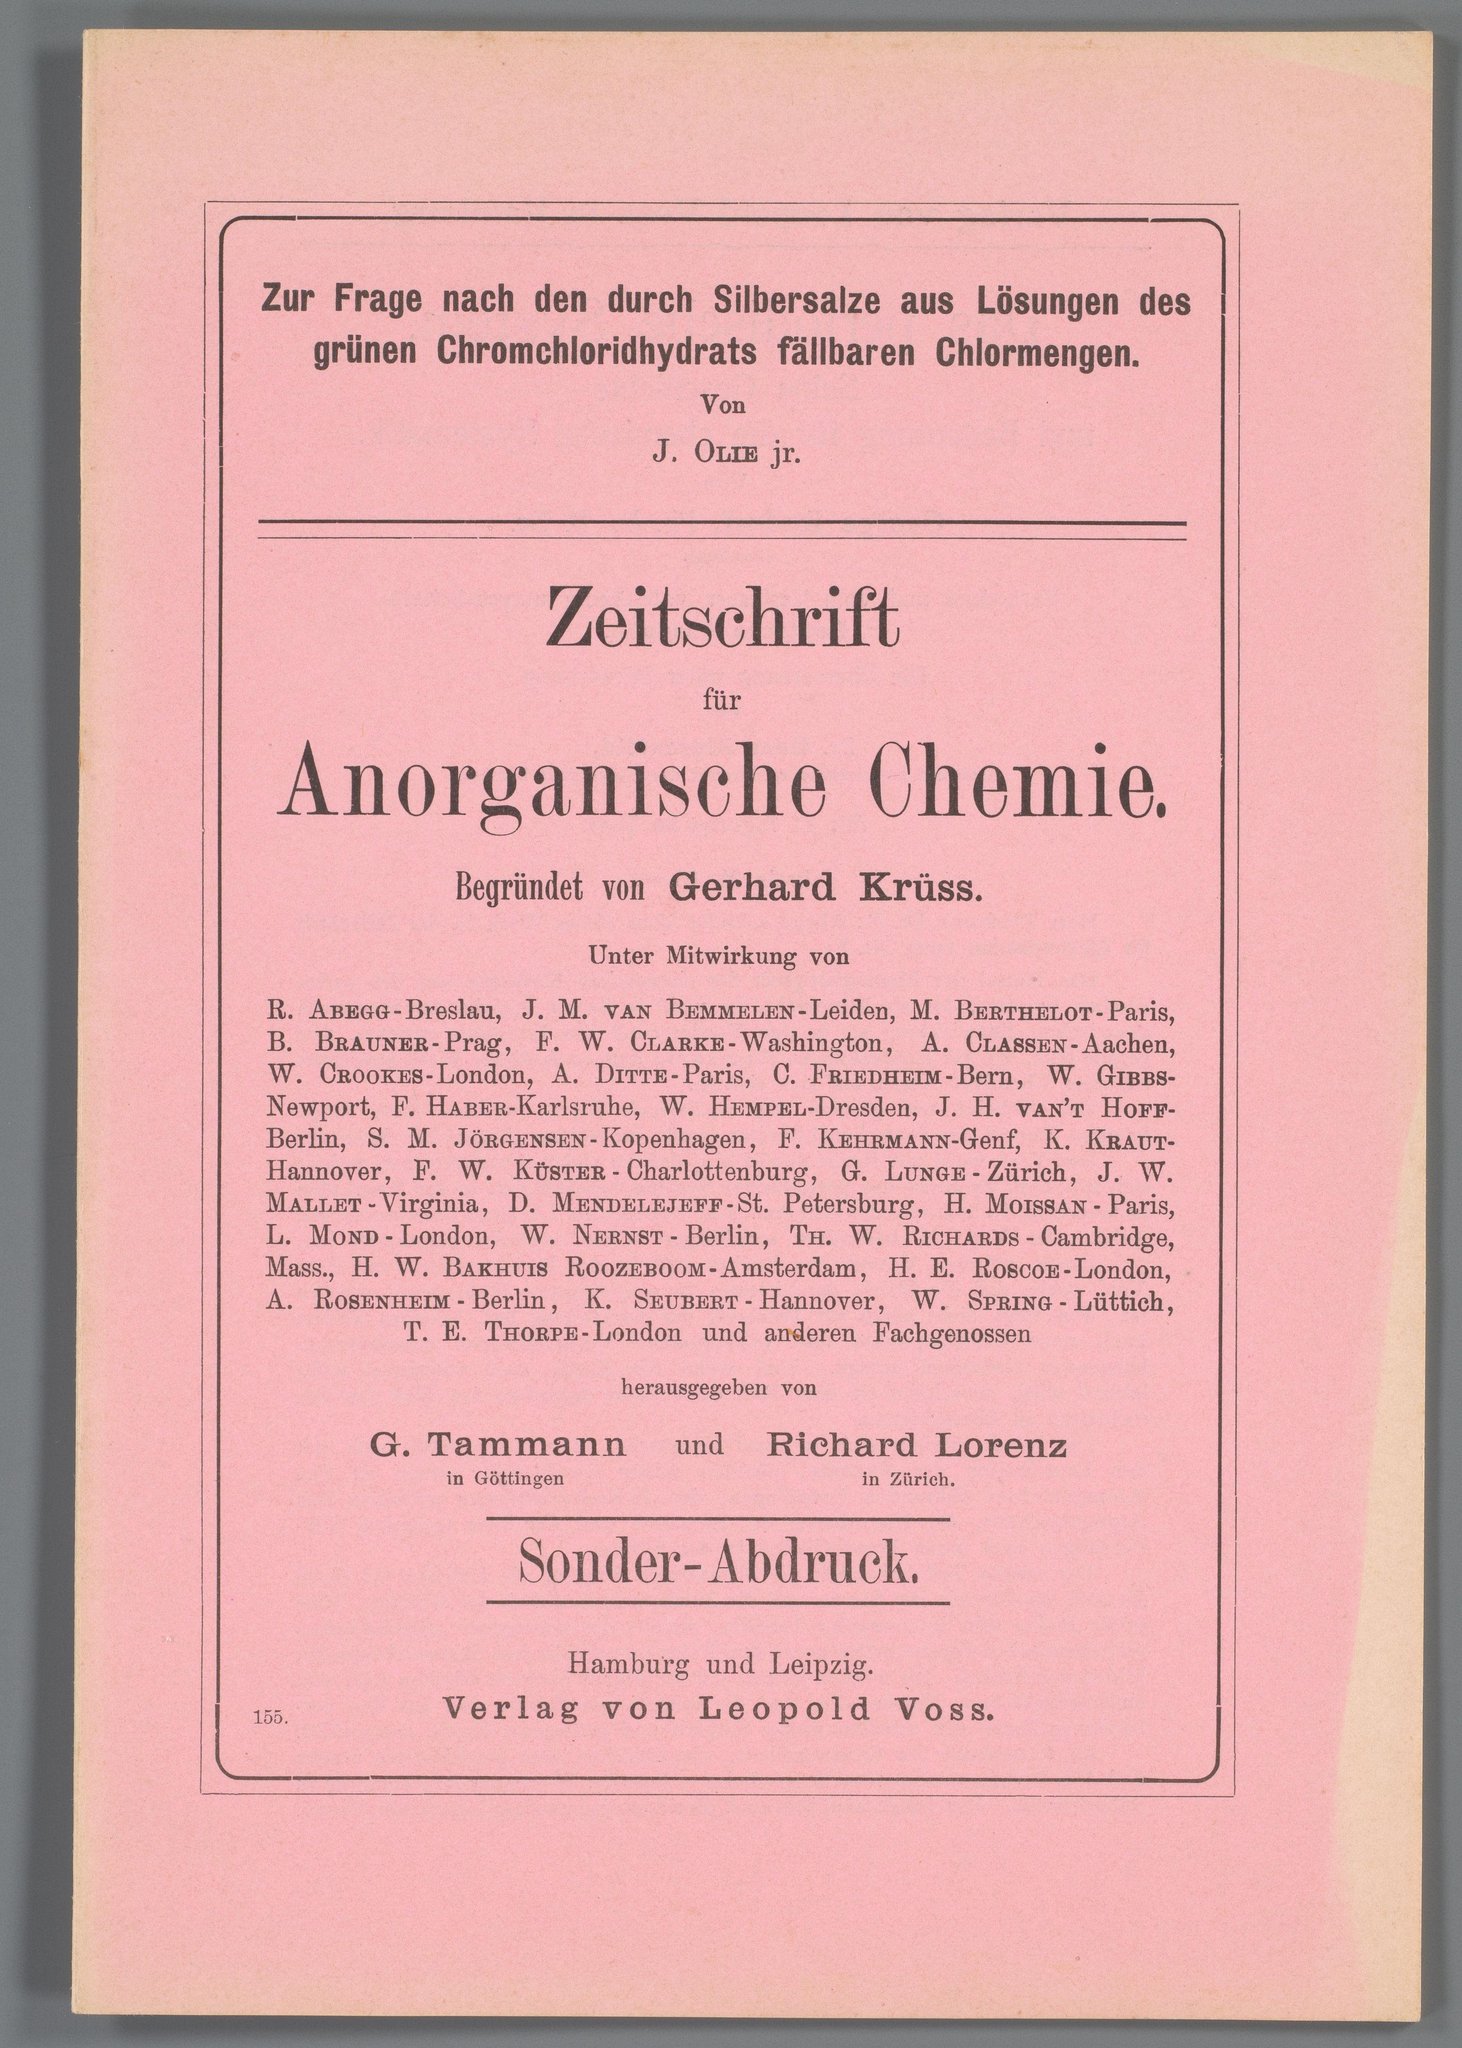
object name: offprint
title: Zeitschrift für Anorganische Chemie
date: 1905-1910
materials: paper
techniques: letterpress printing, printing block, engraving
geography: leipzig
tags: printed matter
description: Overdruk uit het 'Zeitschrift für Anorganische Chemie'.